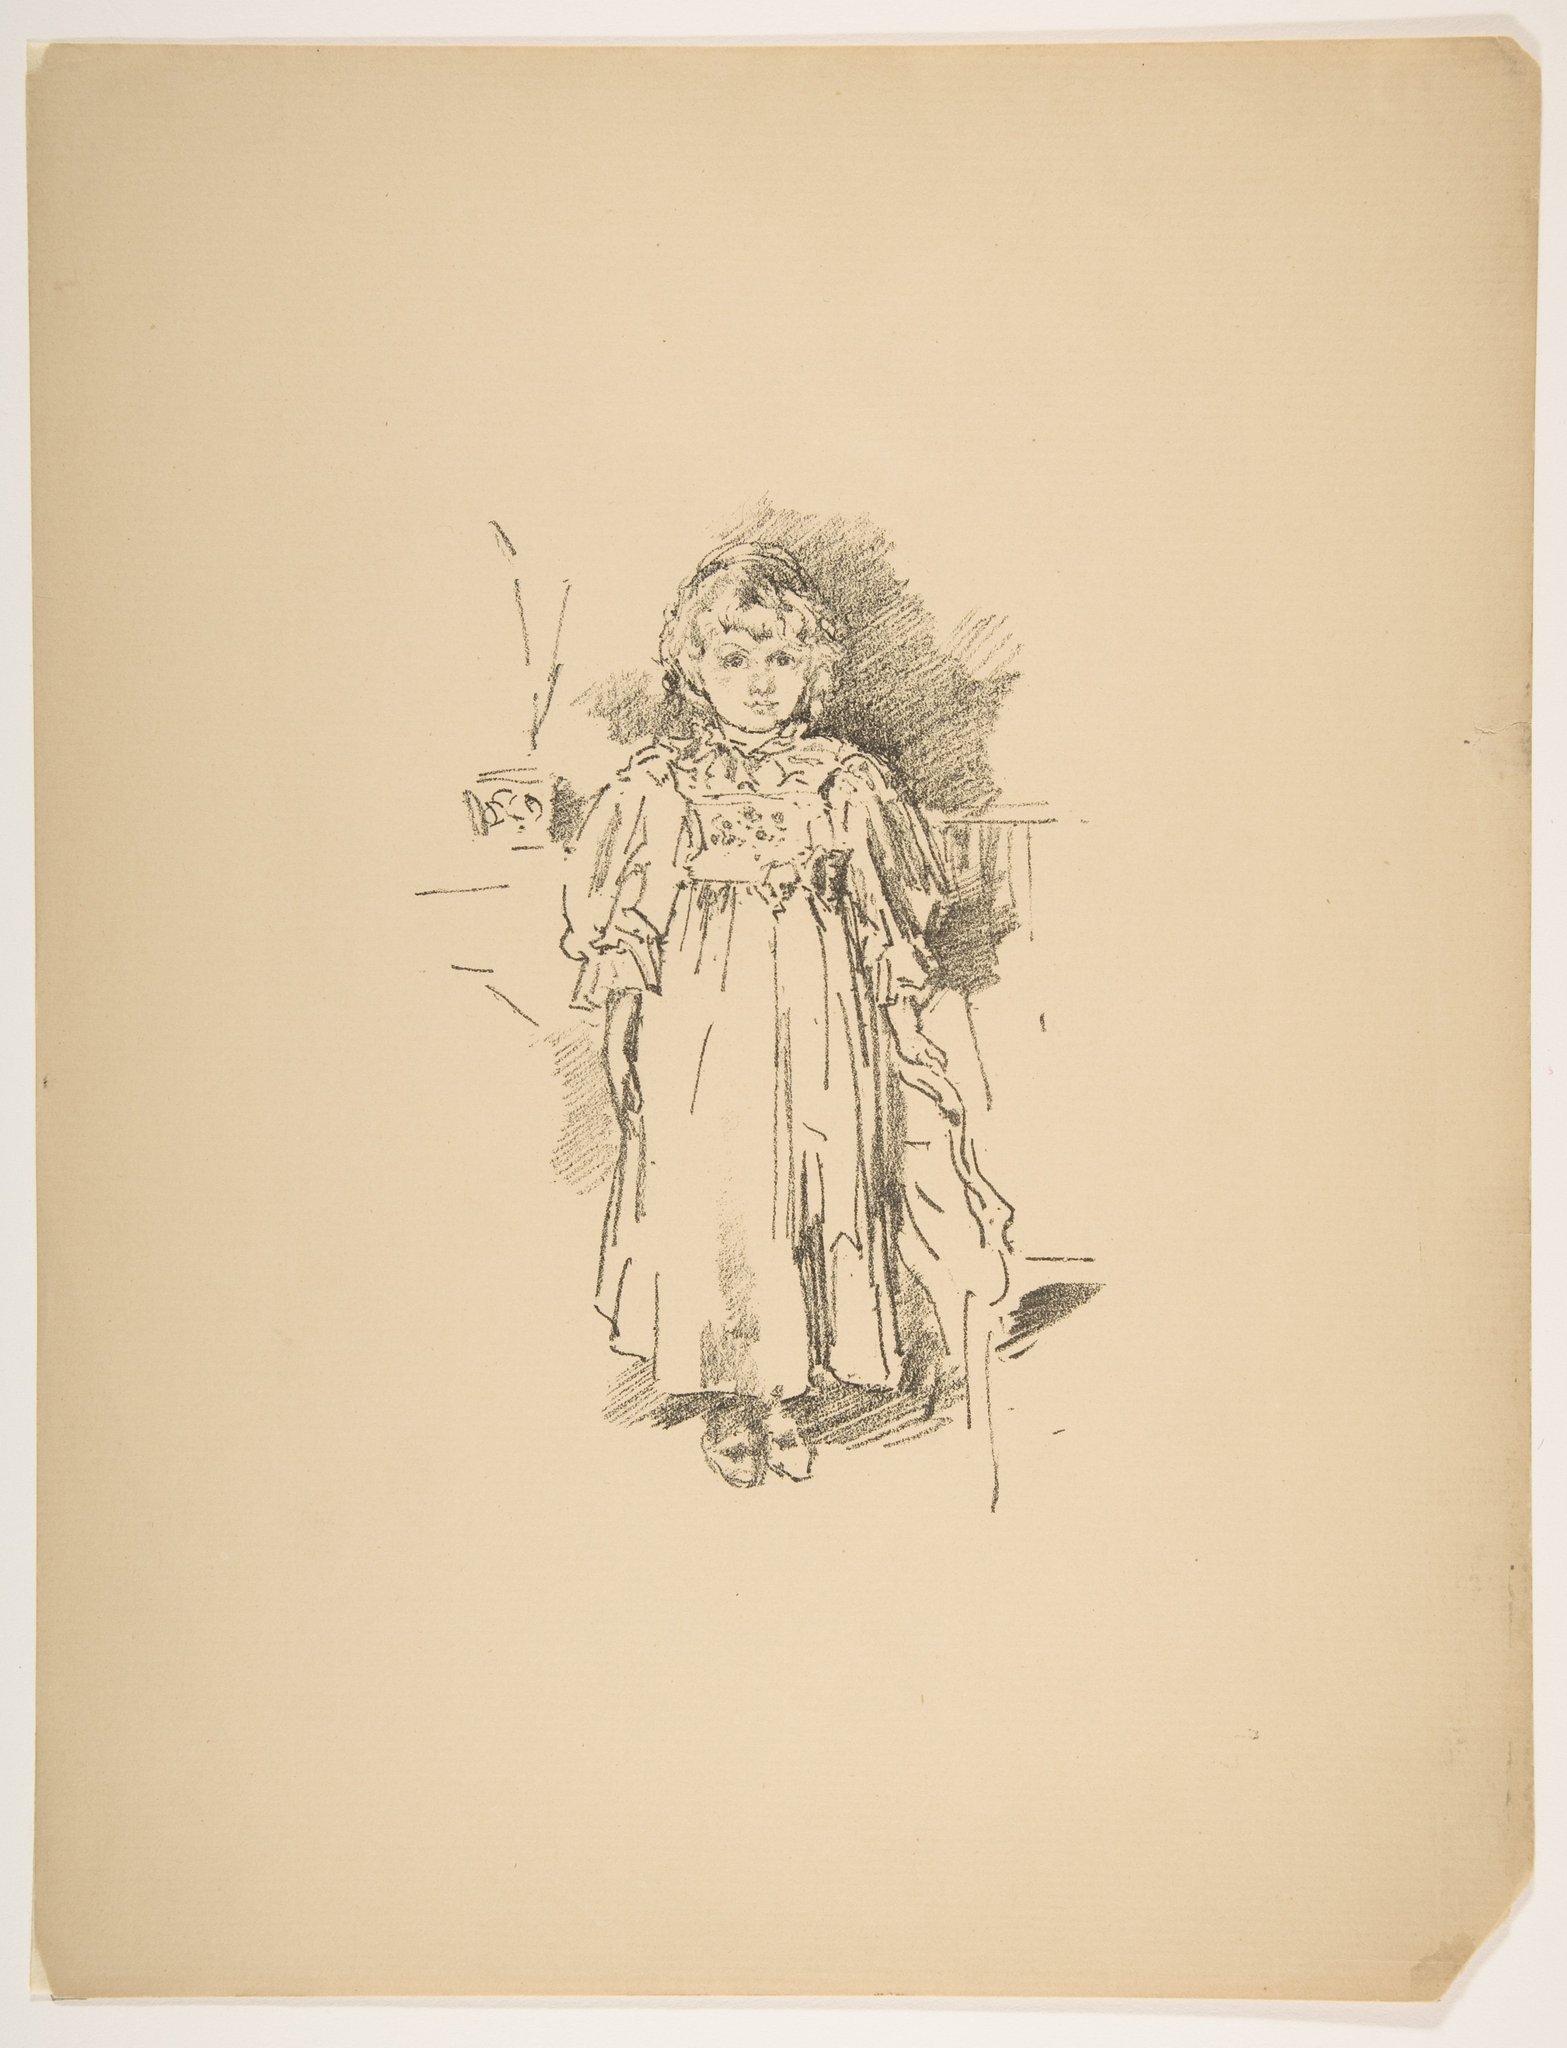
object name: print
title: Little Evelyn, from "The Art Journal," opposite p. 88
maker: james mcneill whistler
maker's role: artist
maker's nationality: american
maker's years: 1834-1903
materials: ink, paper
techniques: printing, lithography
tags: girls